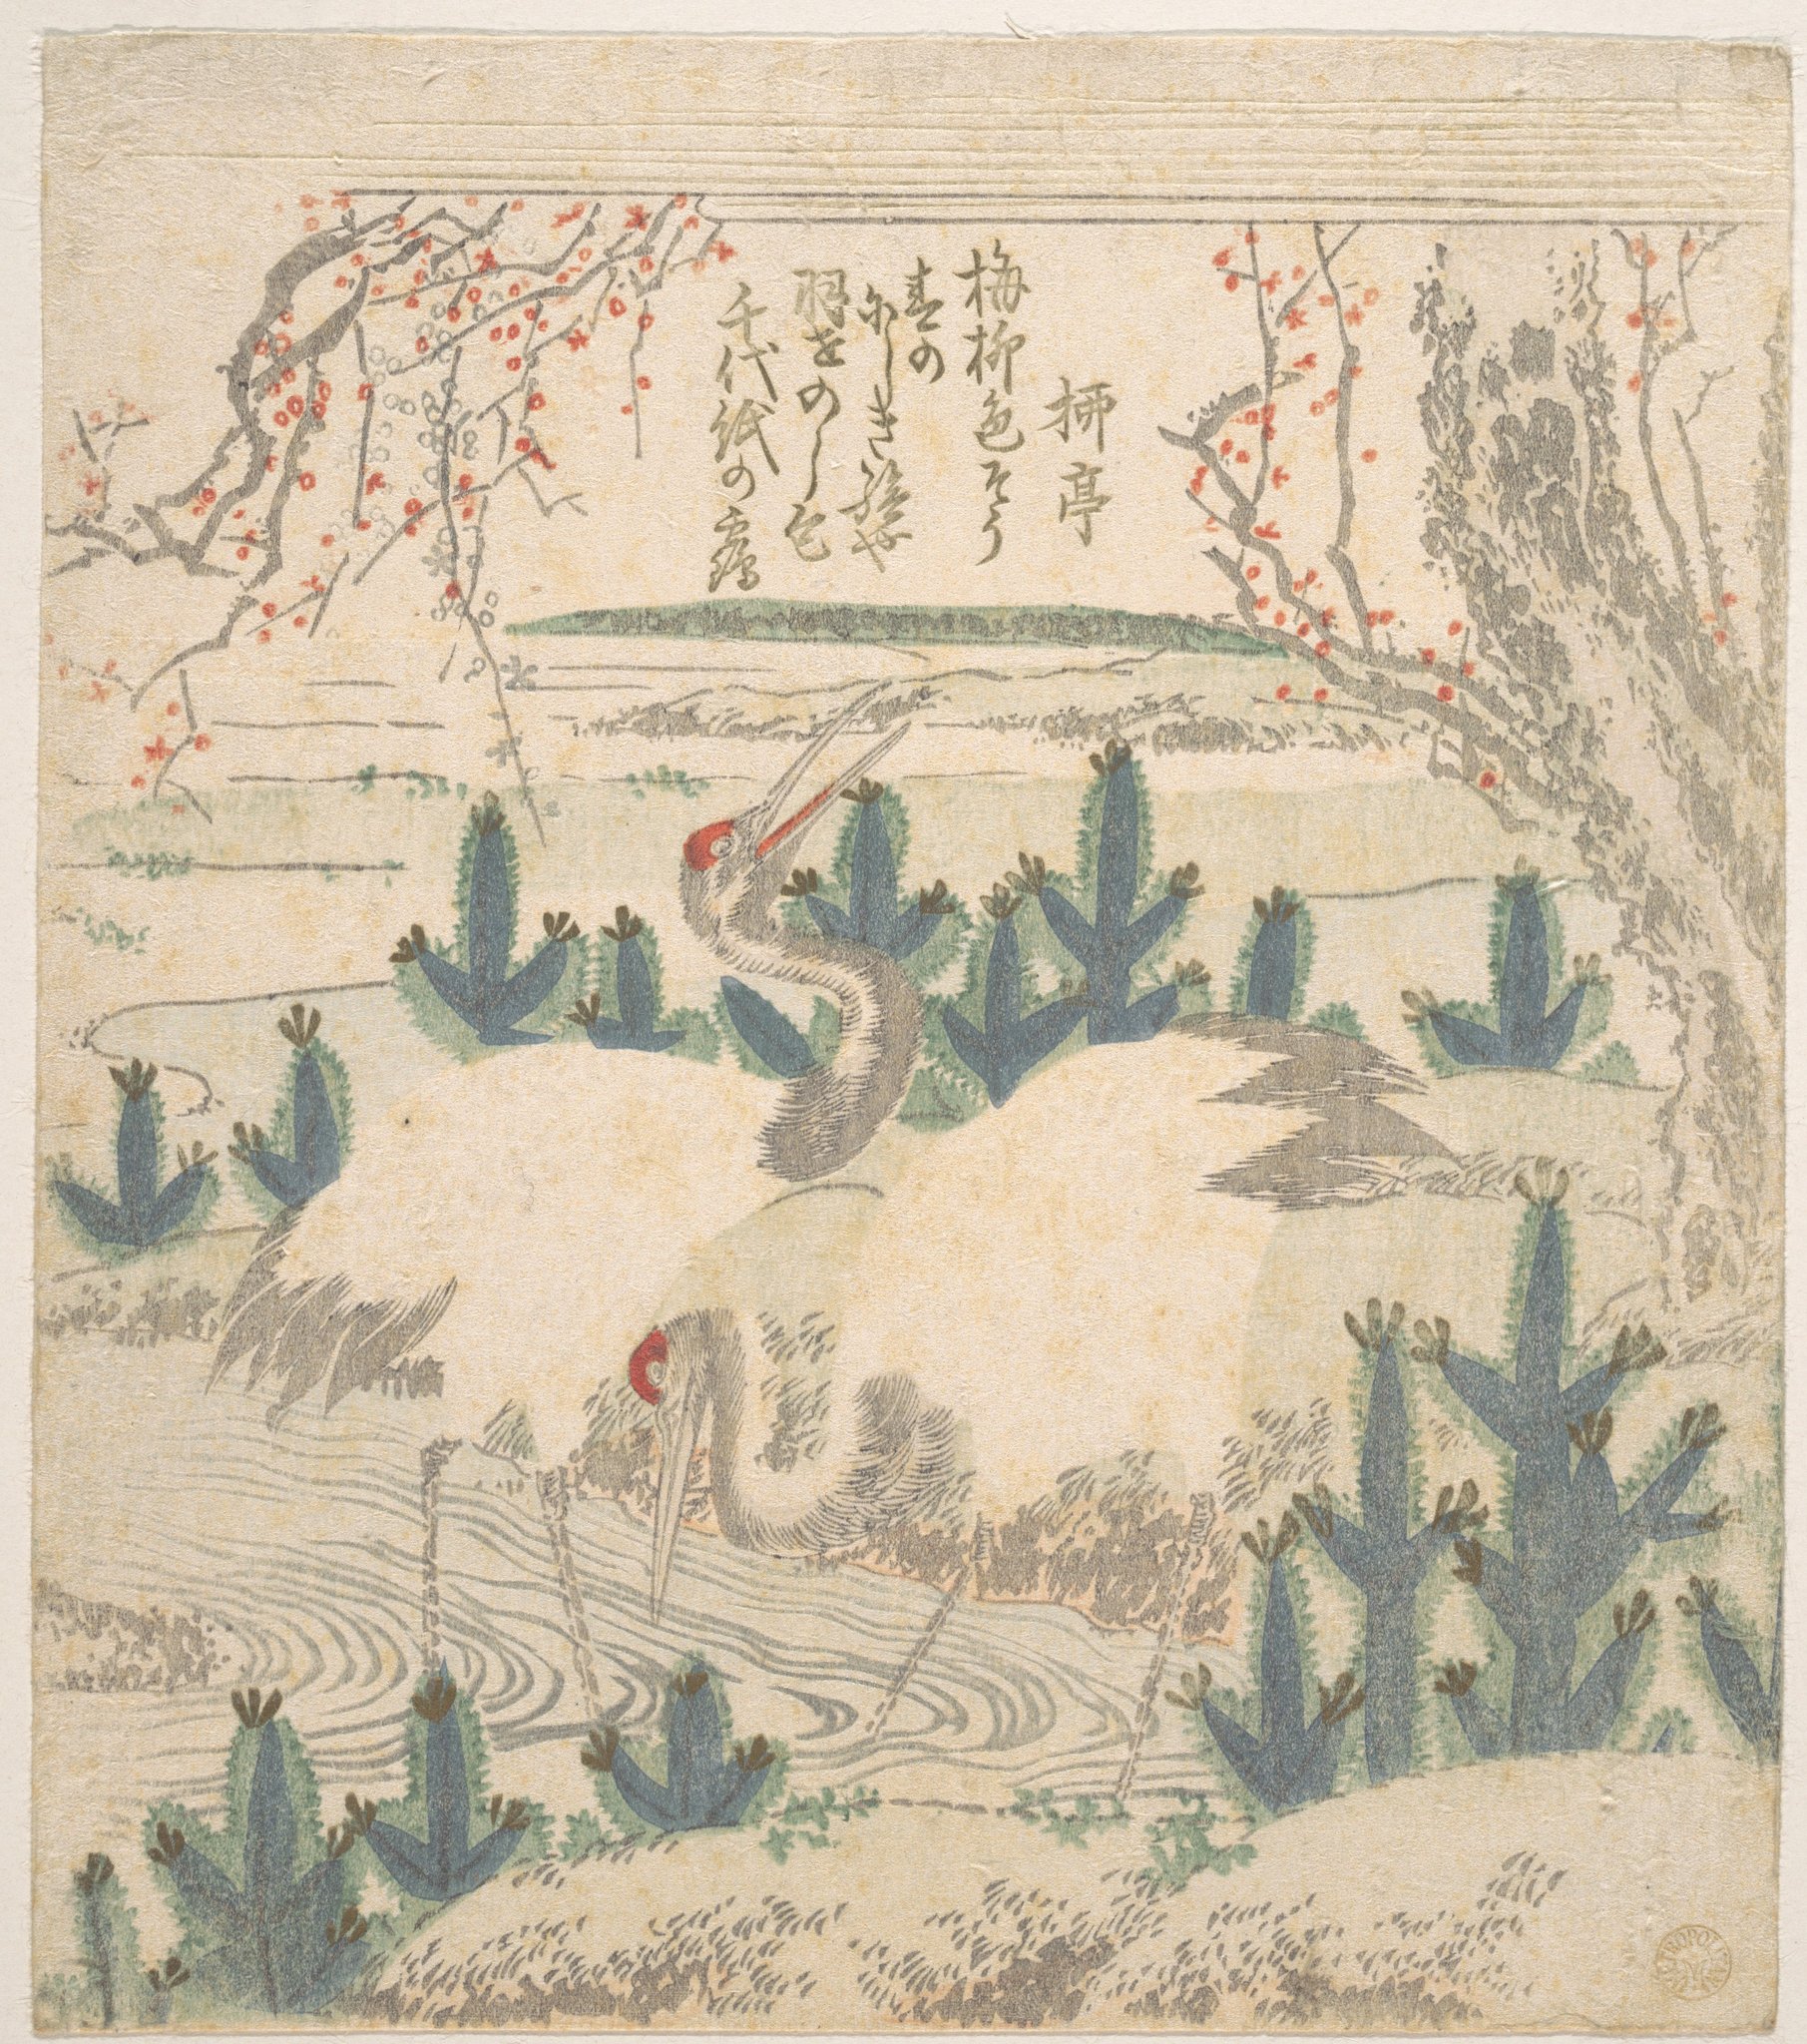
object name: print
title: Cranes Among Young Pines Near a Stream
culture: japanese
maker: unidentified artist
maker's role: artist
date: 1830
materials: ink, paper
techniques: surimono, woodblock print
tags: cranes,trees